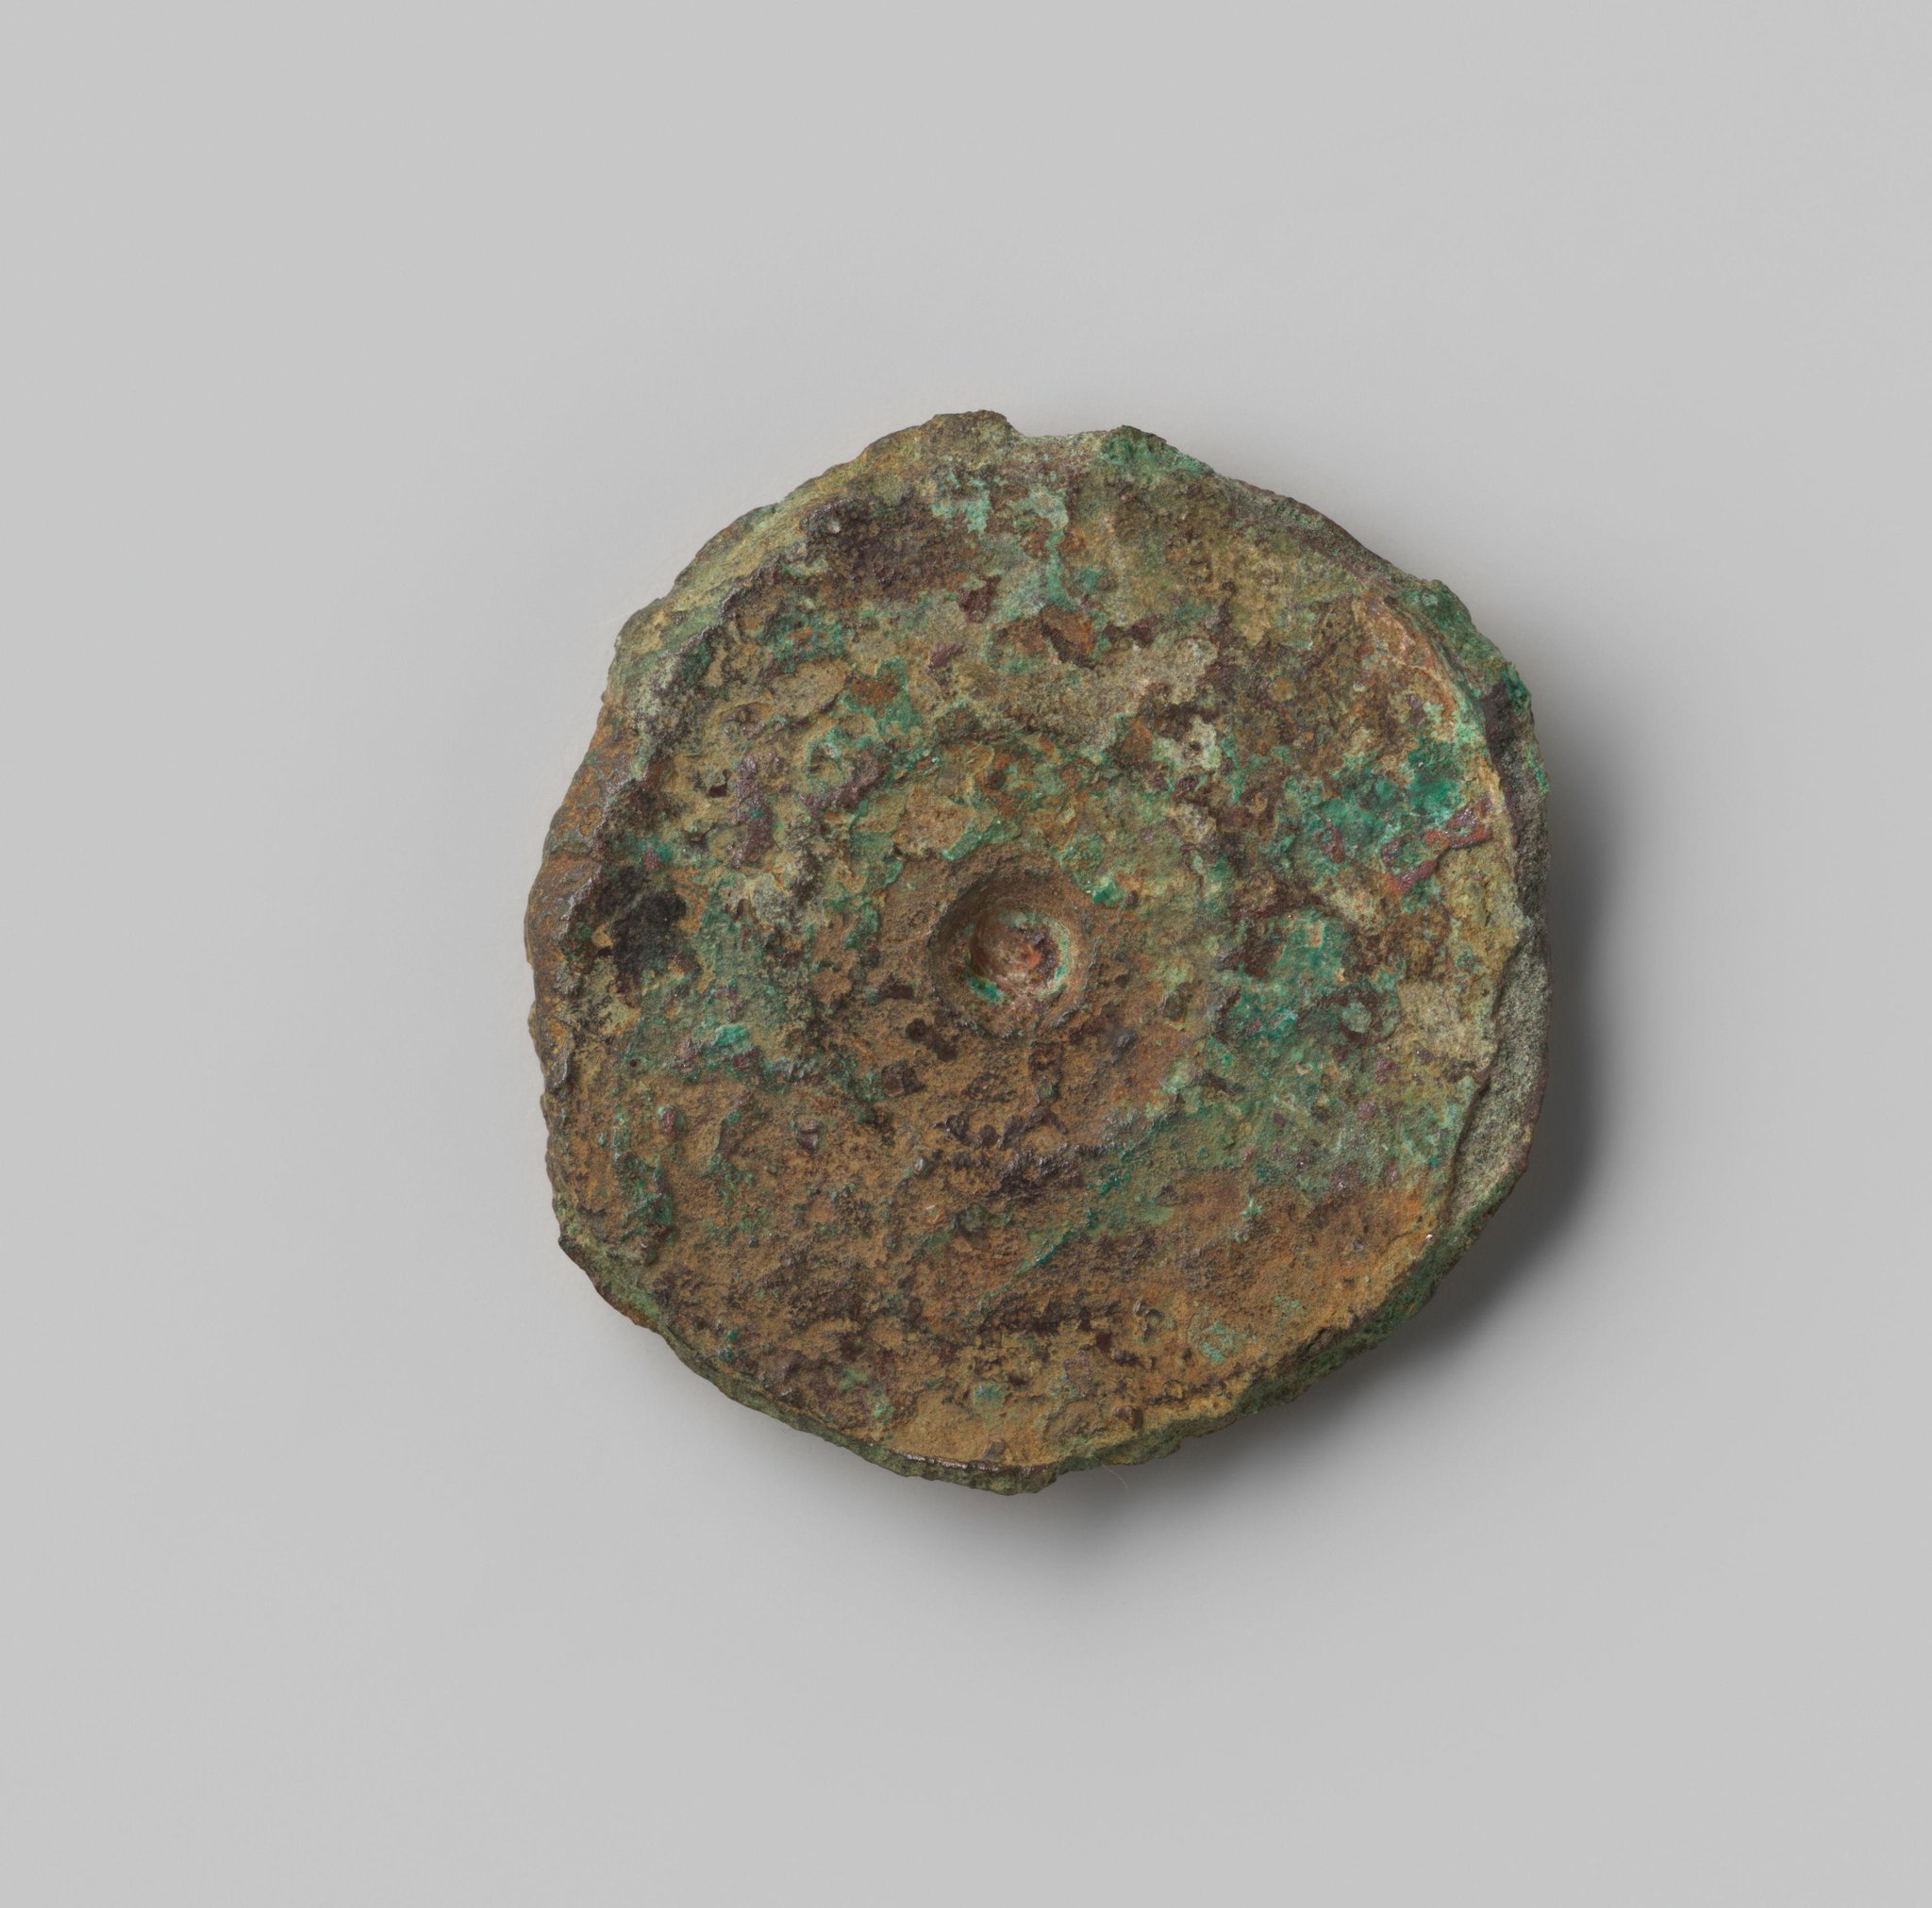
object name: sluitgewicht, pijlgewicht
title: Gewicht van sluitgewicht uit het wrak van de Oost-Indiëvaarder Hollandia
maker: Anonymous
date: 1700-1743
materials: copper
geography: netherlands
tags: verenigde oostindische compagnie, hollandia (schip), annet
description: Weight, cupweight, cup; fragment, bottom of cup, id. NG 1980-27H2775, corroded, no marks legible.